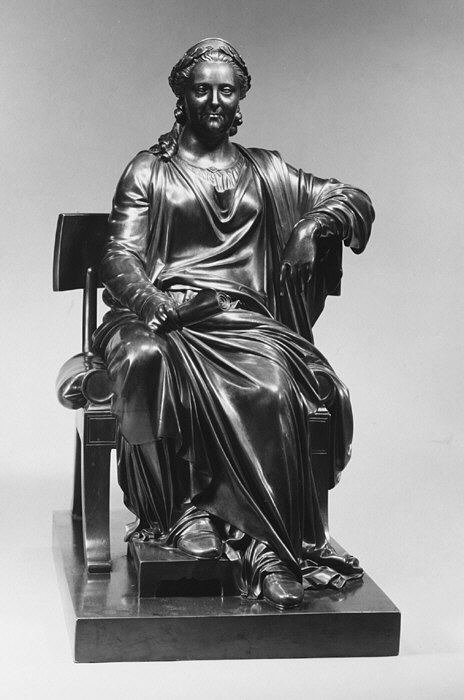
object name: statuette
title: Empress Catherine II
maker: samuel friedrich ivanovich hallberg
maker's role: artist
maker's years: 1787-1839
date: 1837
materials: bronze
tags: women